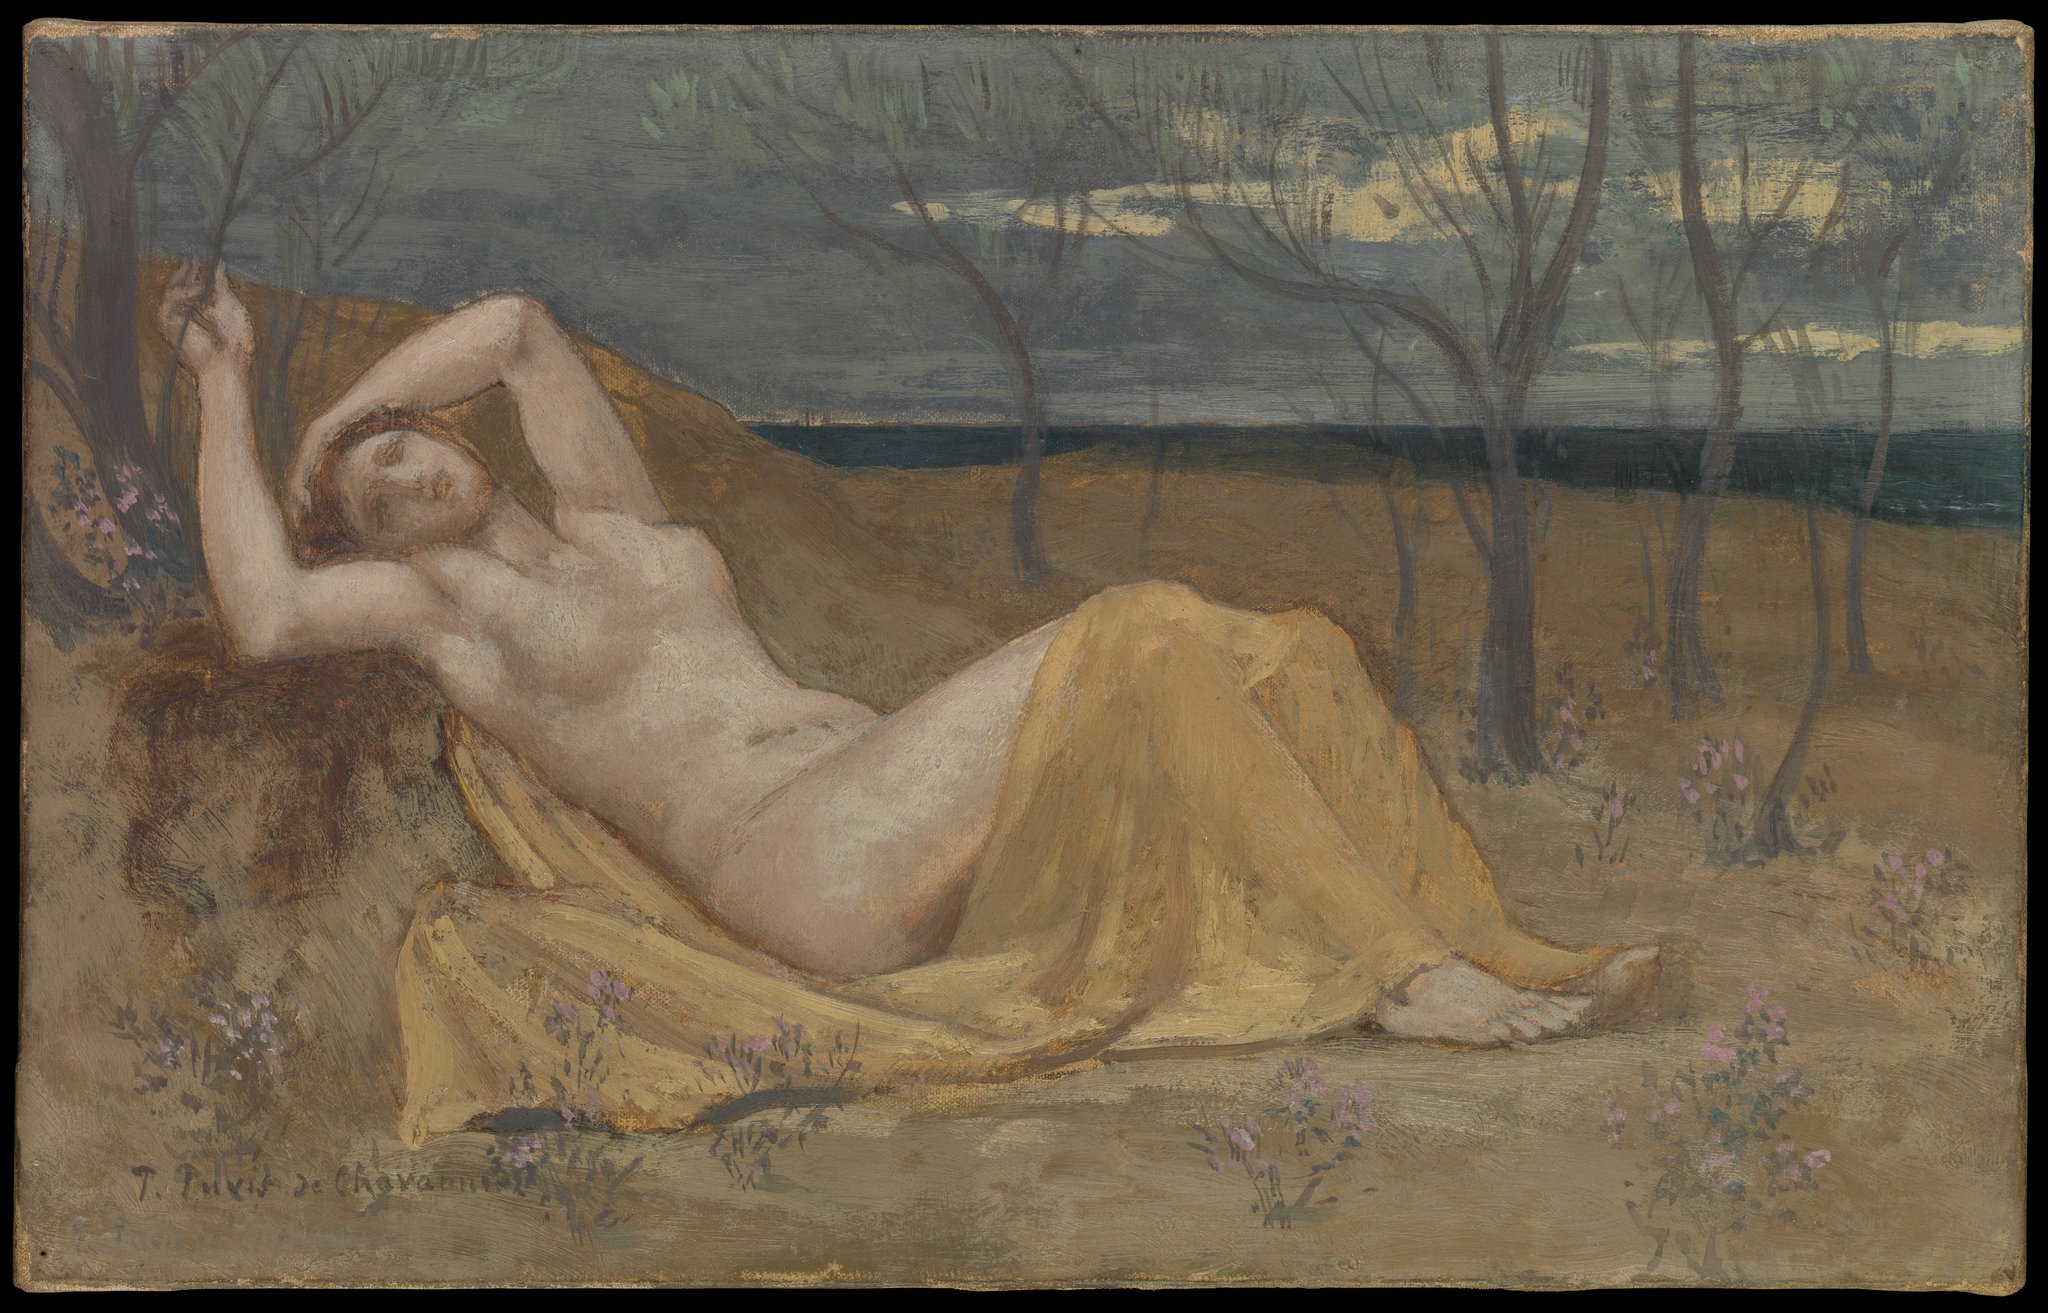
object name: painting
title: Tamaris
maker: pierre puvis de chavannes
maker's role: artist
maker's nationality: french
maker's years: 1824-1898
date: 1886-1887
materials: canvas, oil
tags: female nudes